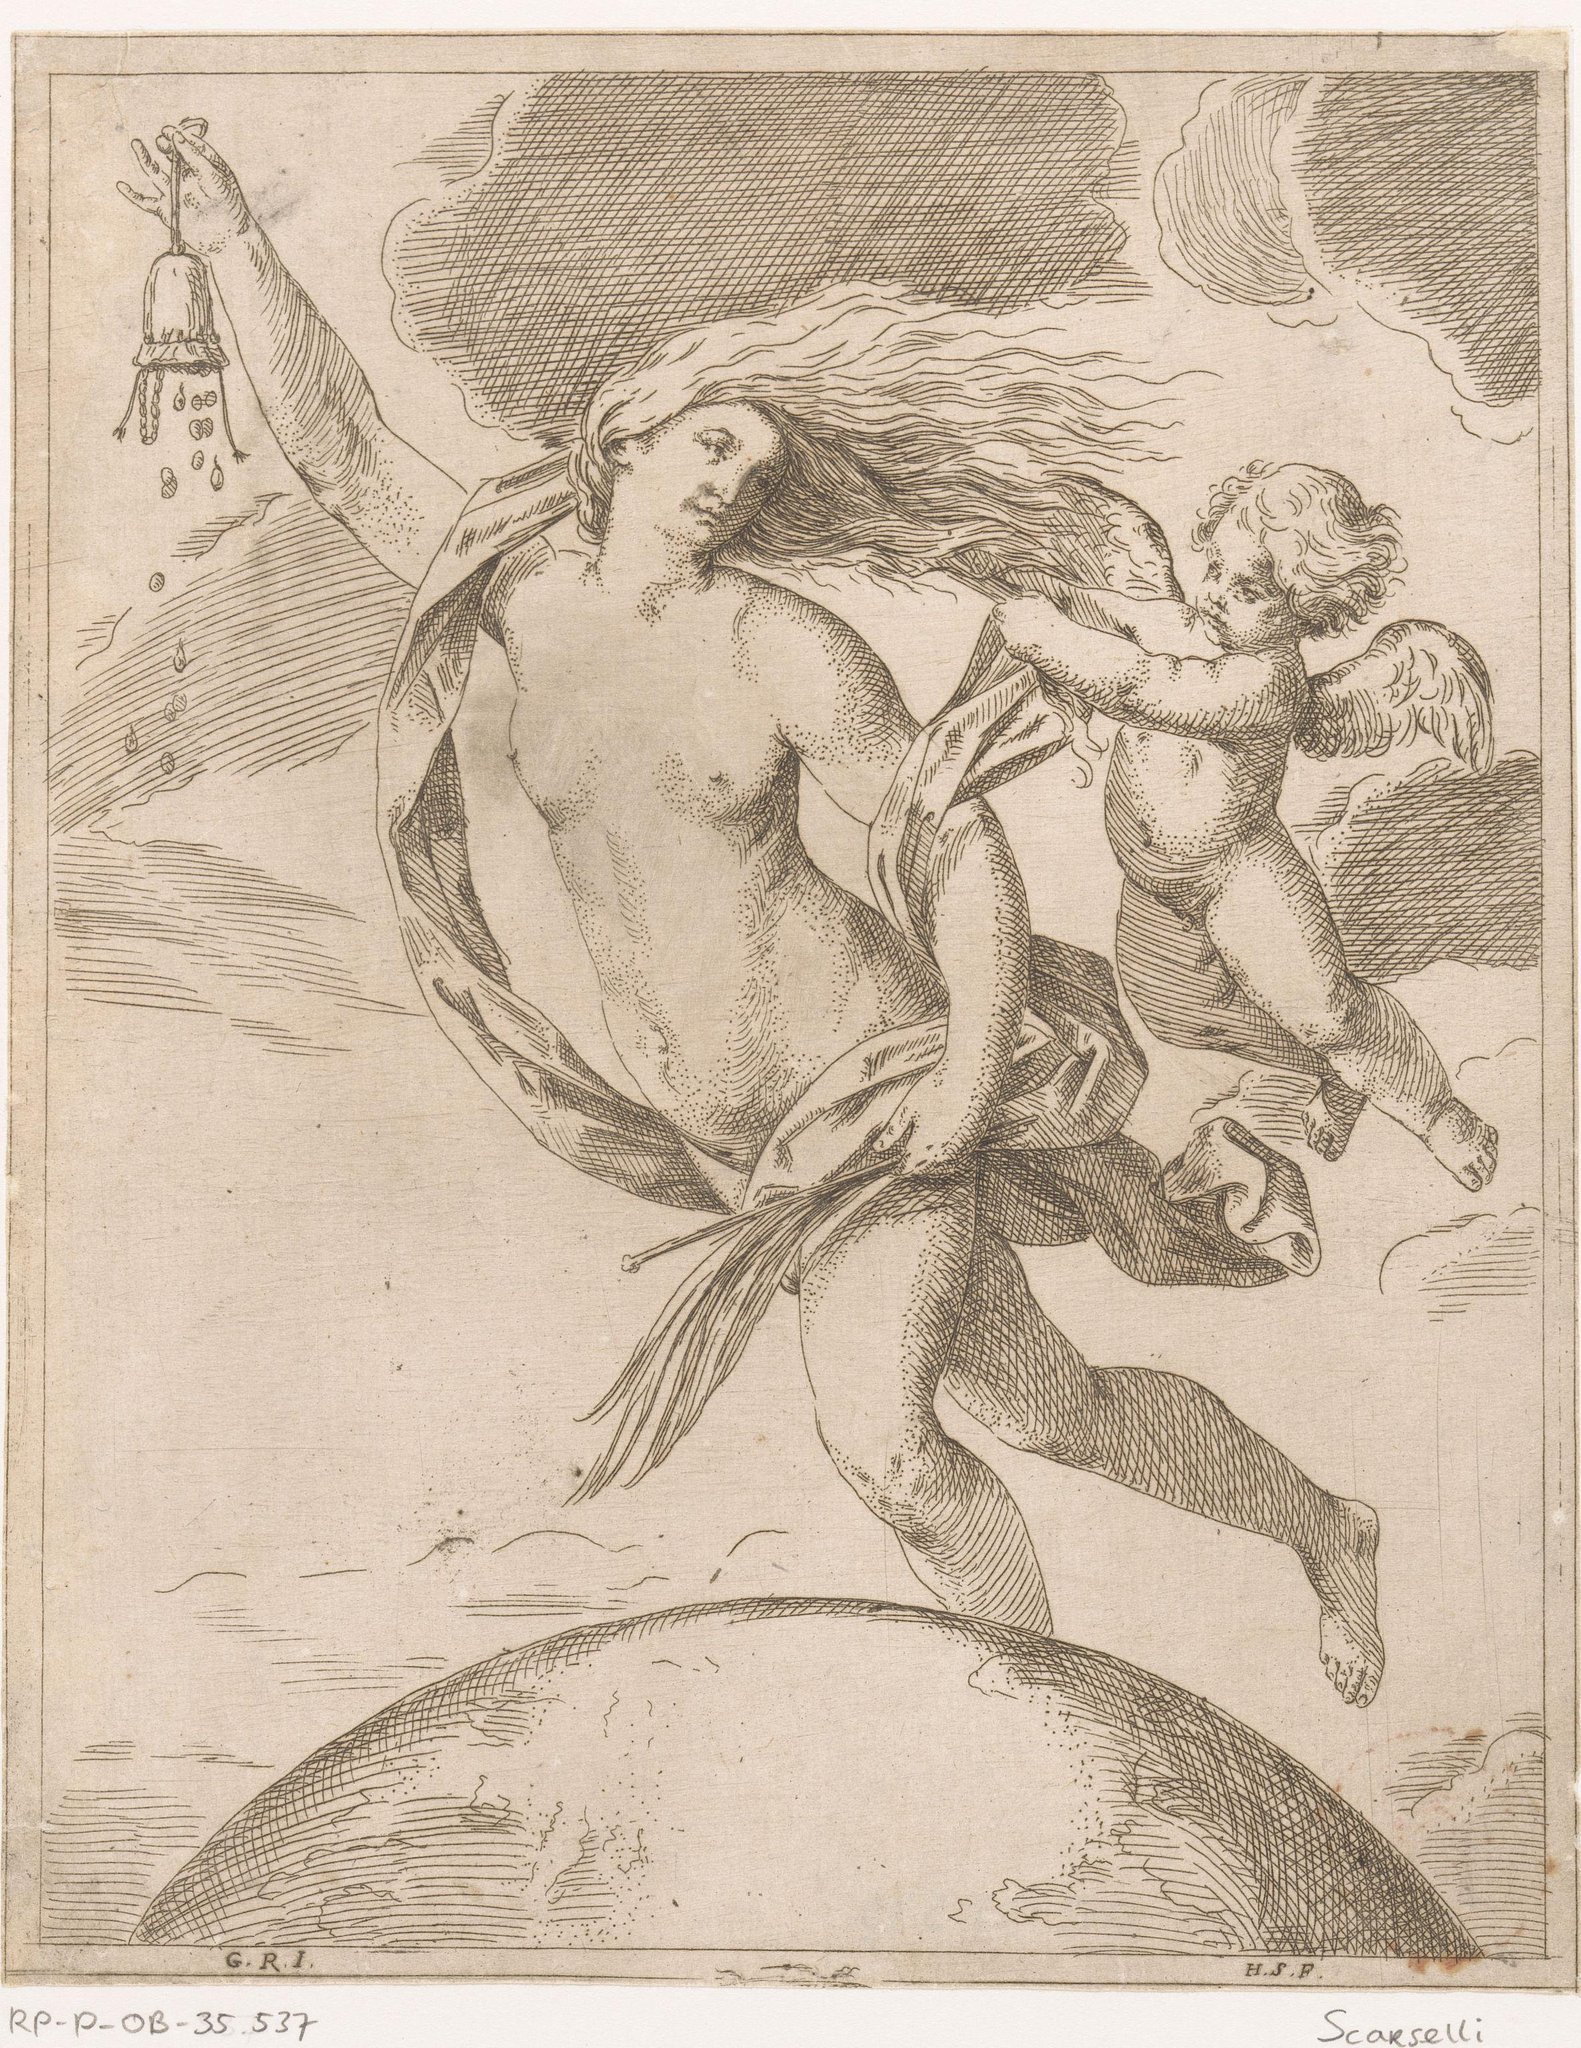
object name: print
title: Fortuna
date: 1665-1675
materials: paper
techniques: etching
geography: italy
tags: luck, fortune, lot; 'fato', 'fortuna', 'fortuna aurea', 'fortuna buona', 'fortuna pacifica overo clemente', 'sorte' (ripa)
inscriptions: collector's mark: Lugt 240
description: Fortuna zweeft over een globe. Ze kiept een zak met munten om. Een putto trekt aan haar haren.